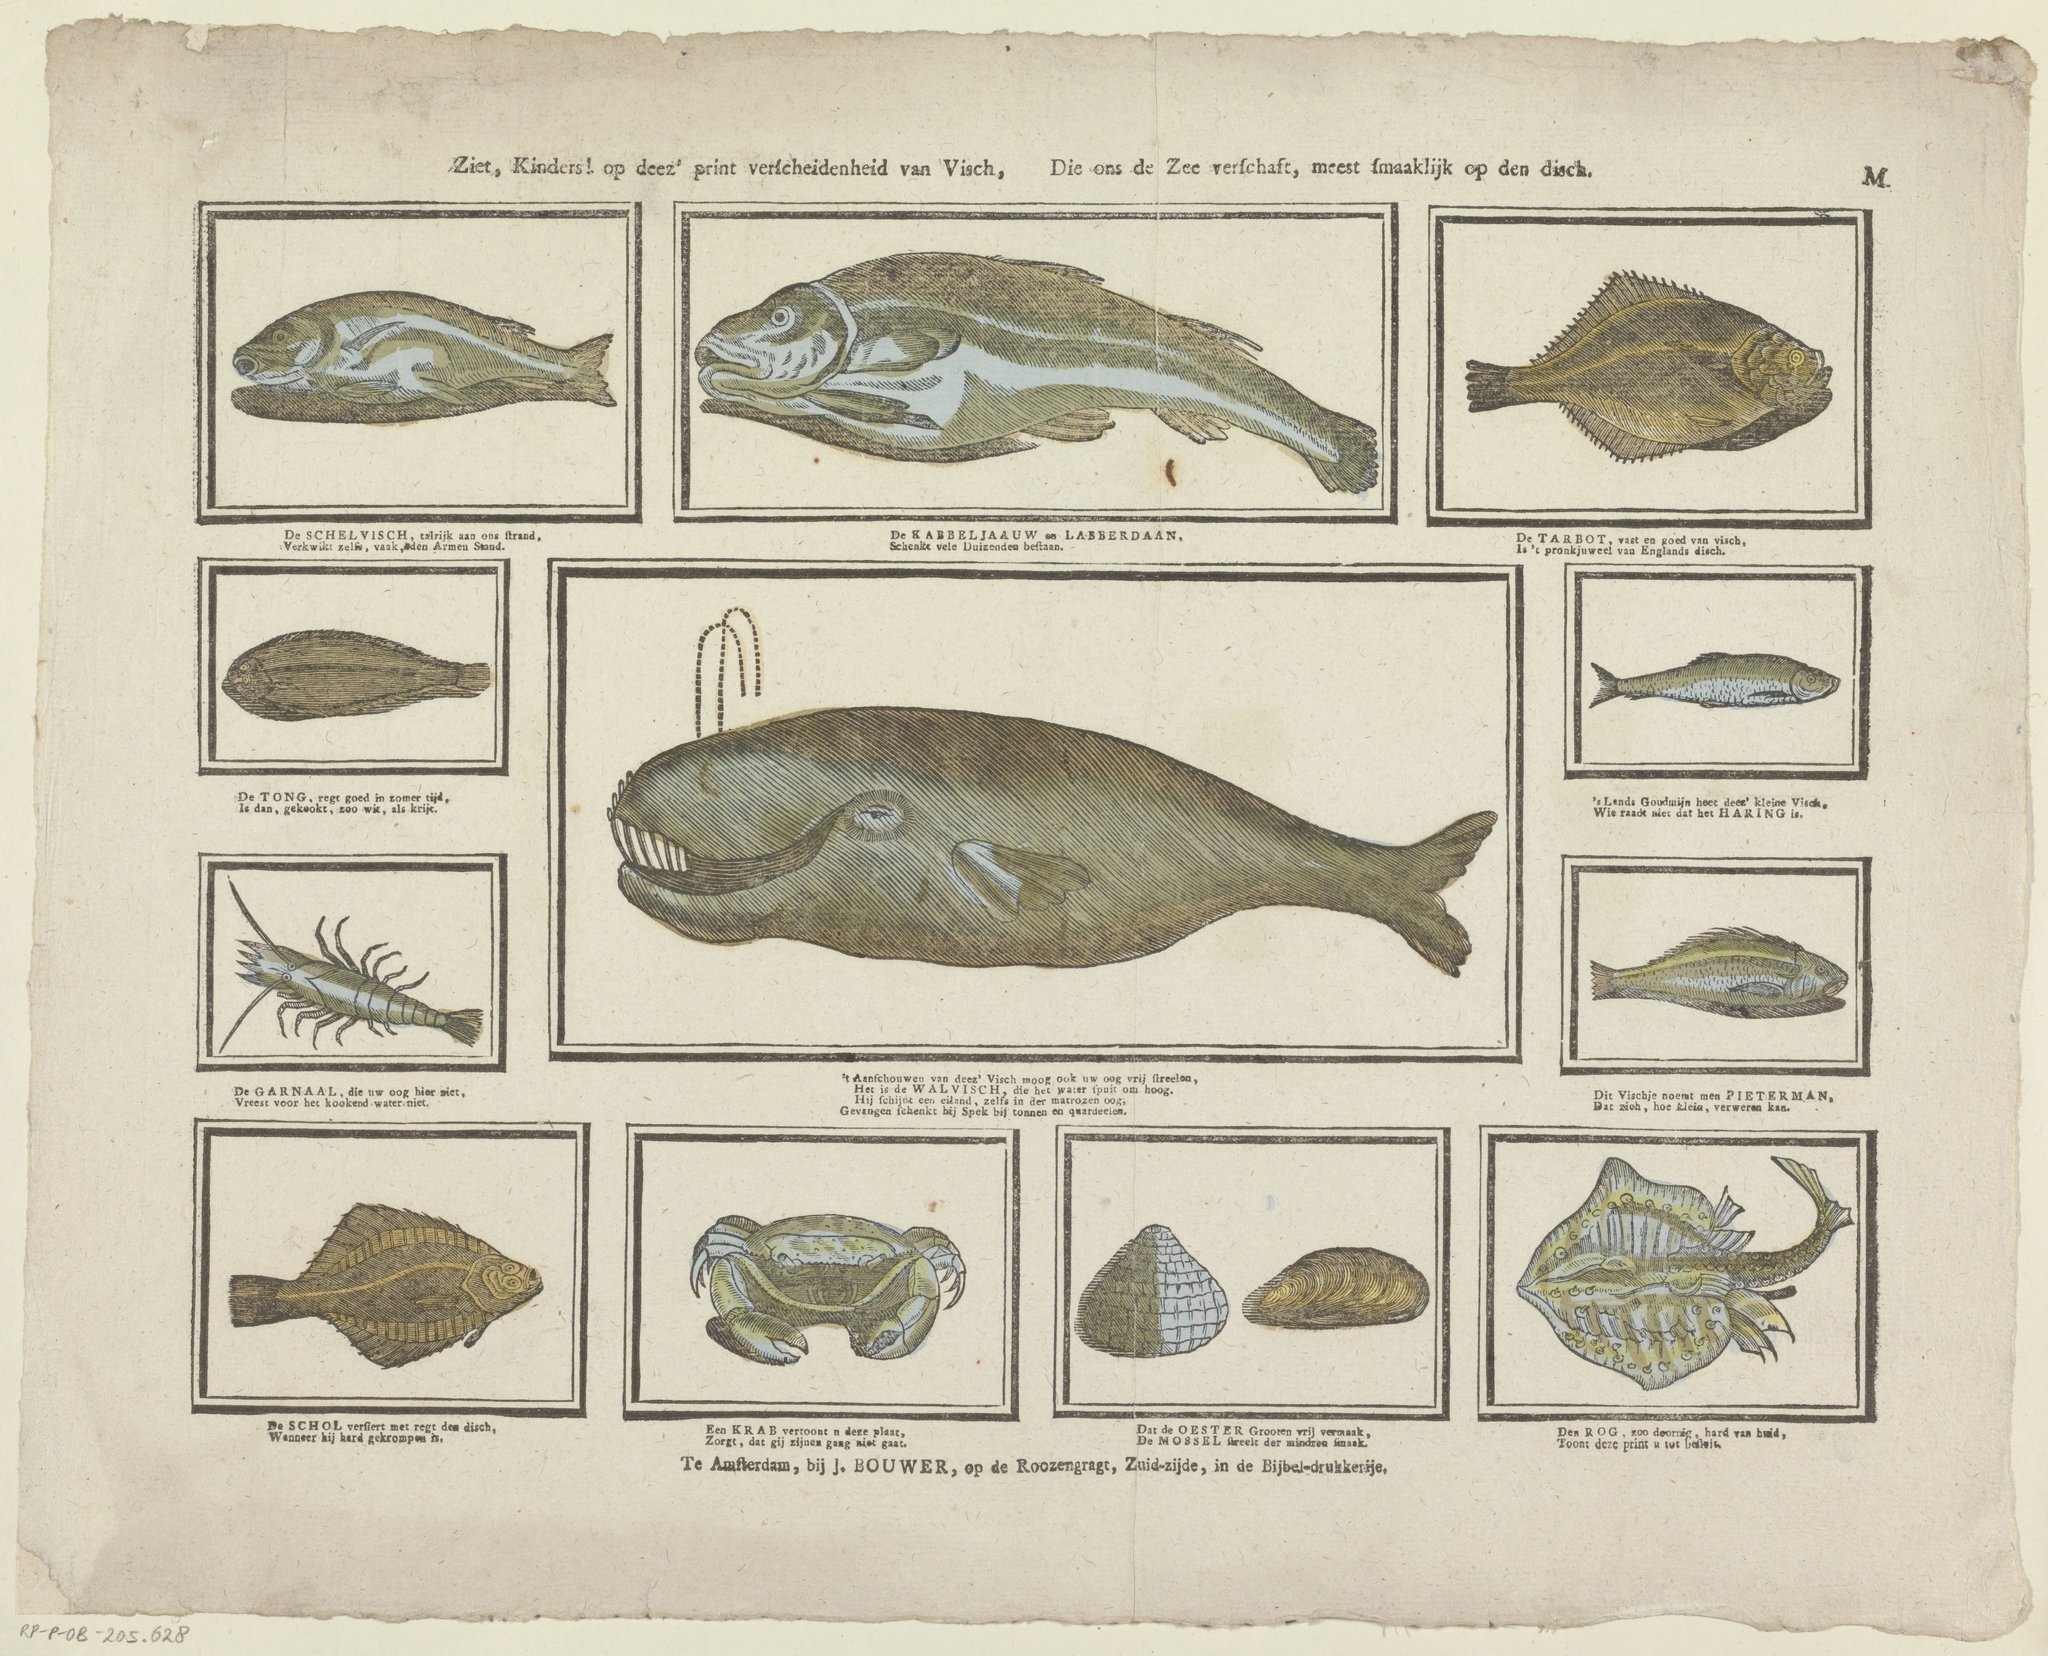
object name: popular print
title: Ziet, kinders! op deez' print verscheidenheid van visch, Die ons de zee verschaft, meest smaaklijk op den disch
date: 1805-1808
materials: paper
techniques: colour, letterpress printing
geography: netherlands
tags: arthropods, fishes, molluscs, swimming mammals: whale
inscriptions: collector's mark: Lugt 2760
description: Blad met 12 voorstellingen van vissen, een walvis en schaaldieren. Onder elke afbeelding een tweeregelig vers met de naam van het dier. Genummerd rechtsboven: M.